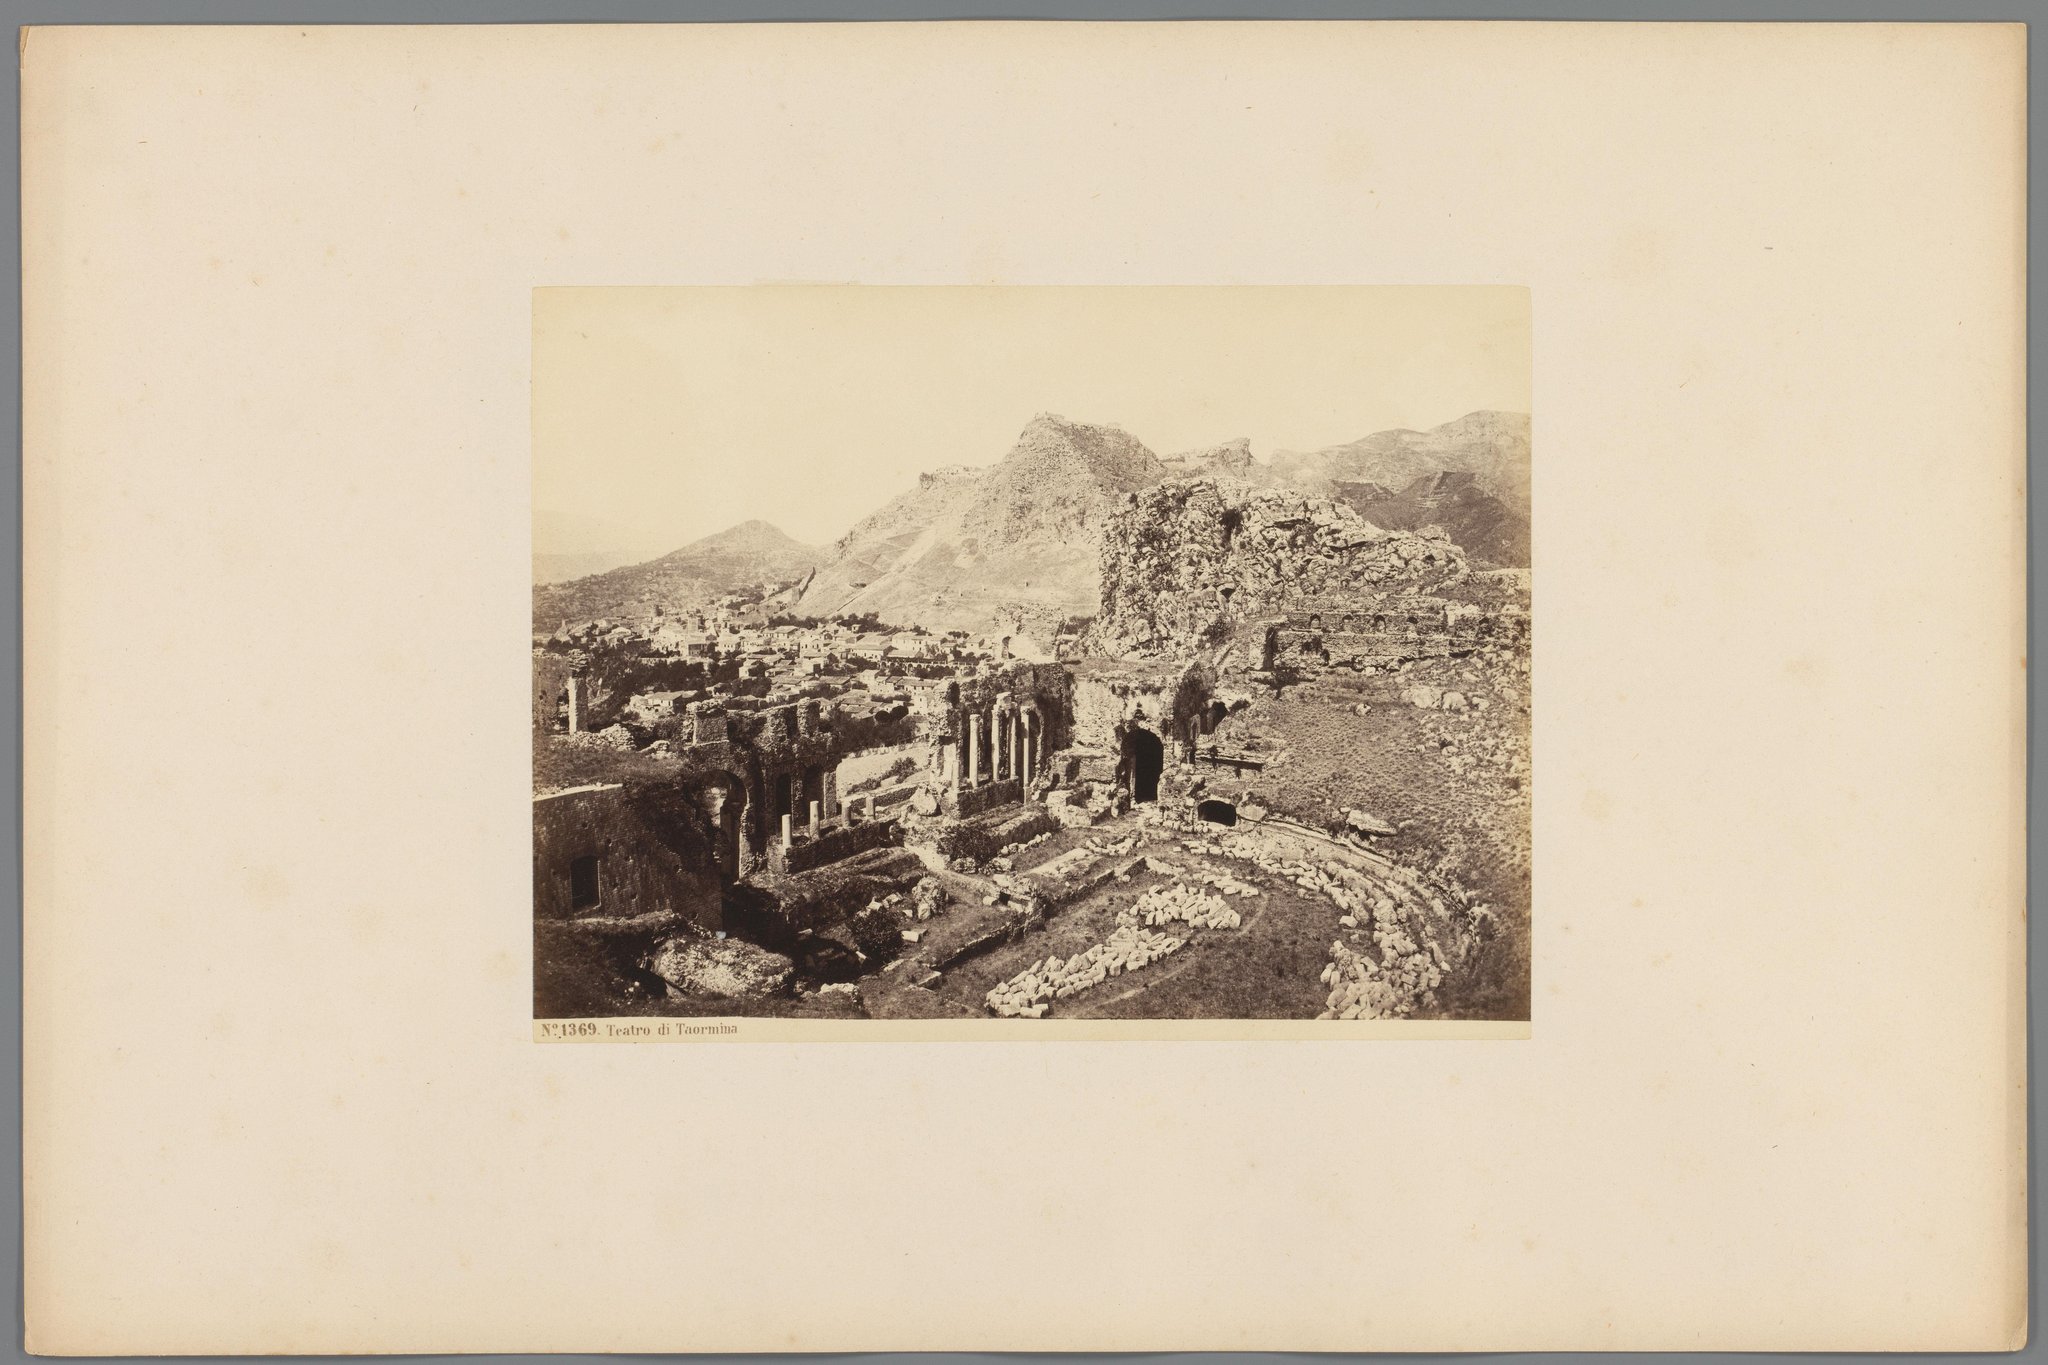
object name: photograph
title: Teatro di Taormina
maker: Anonymous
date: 1851-1900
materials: cardboard, paper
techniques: albumen print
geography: taormina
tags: amphitheatre, landscape with ruins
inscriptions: number: ‘No. 1369.’